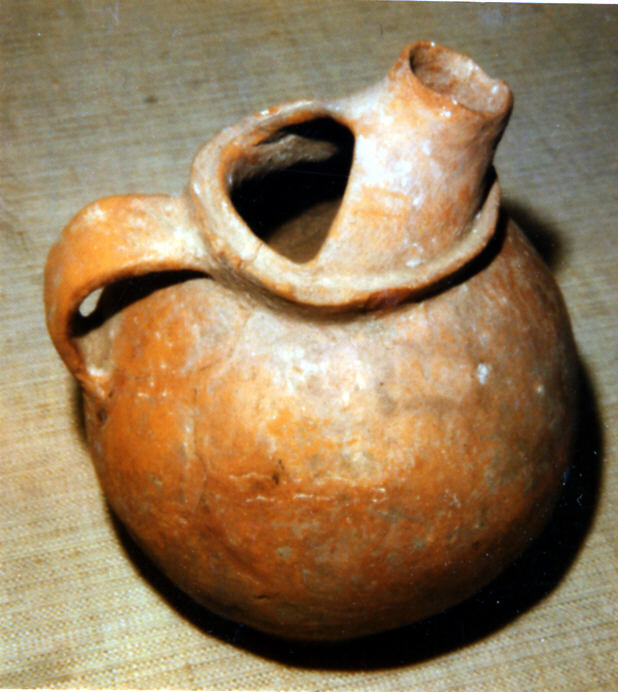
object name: pitcher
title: Pitcher (Hu)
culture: chinese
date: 2500 BCE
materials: earthenware